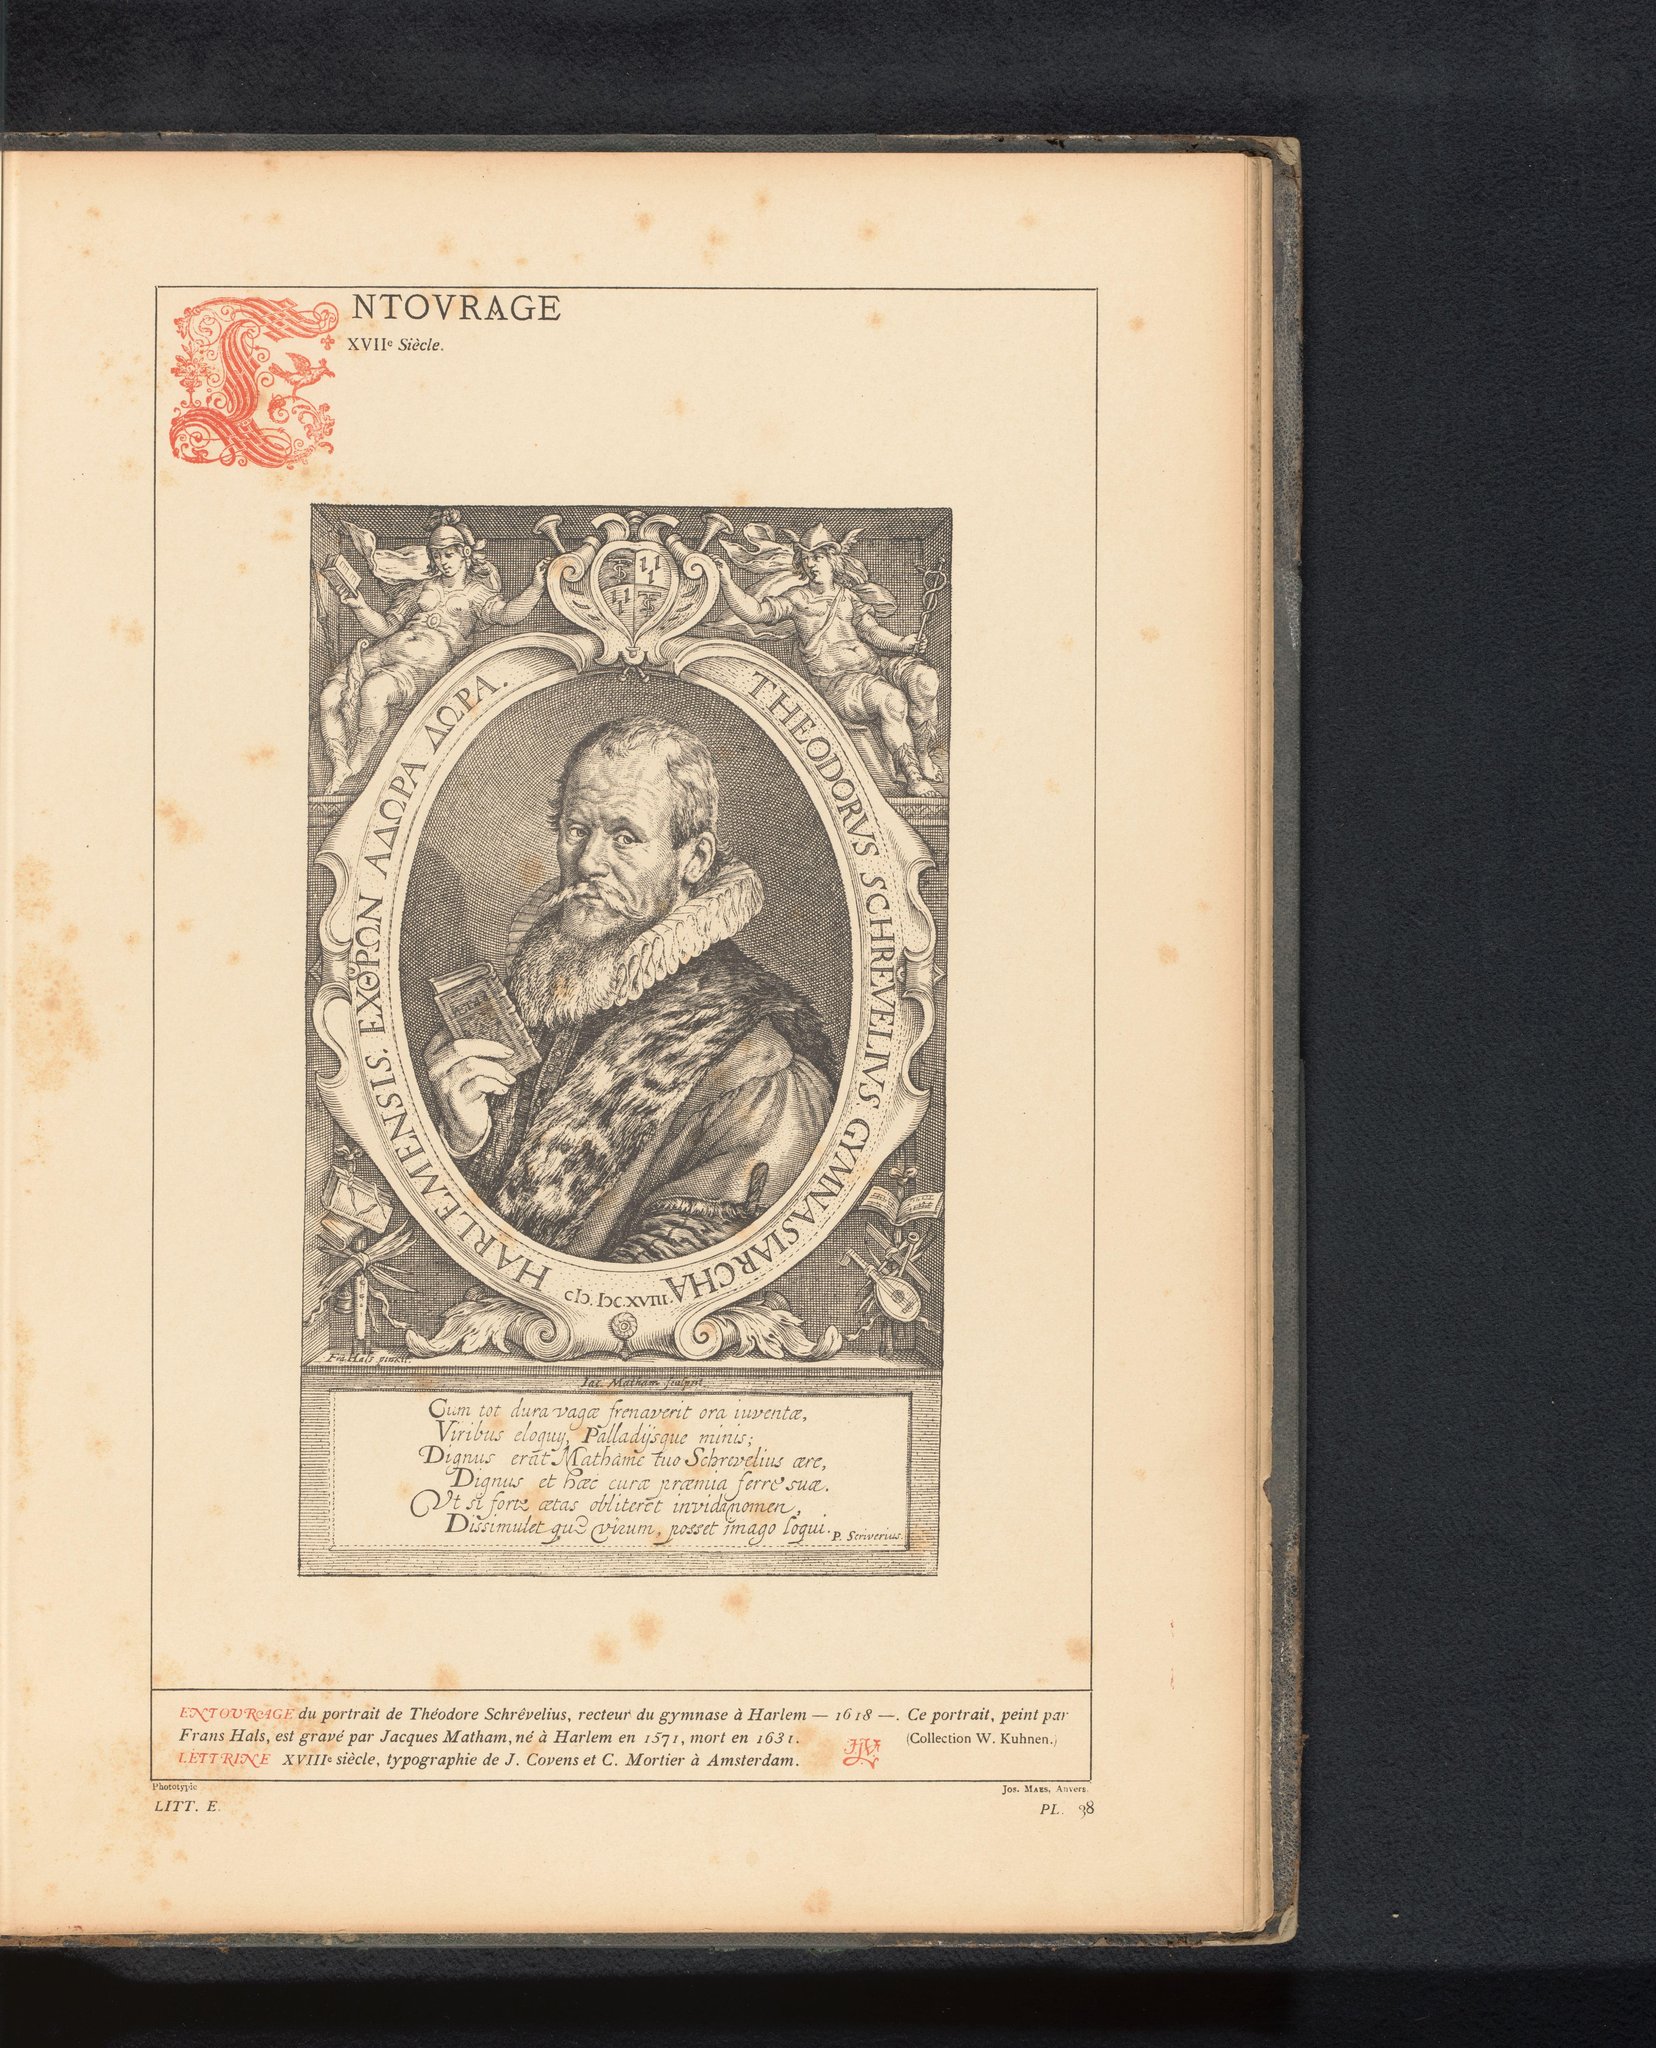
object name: photomechanical print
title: Reproductie van een prent van een portret van Theodorus Schrevelius door Jacob Matham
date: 1875-1880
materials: paper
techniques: photolithography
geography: amsterdam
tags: haarlem, leiden, theodorus schrevelius, historical persons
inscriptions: inscription: ‘LITT. E. - PL. 38’, monogram: ‘JJvY’, inscription: ‘ENTOURAGE du portrait (...)’